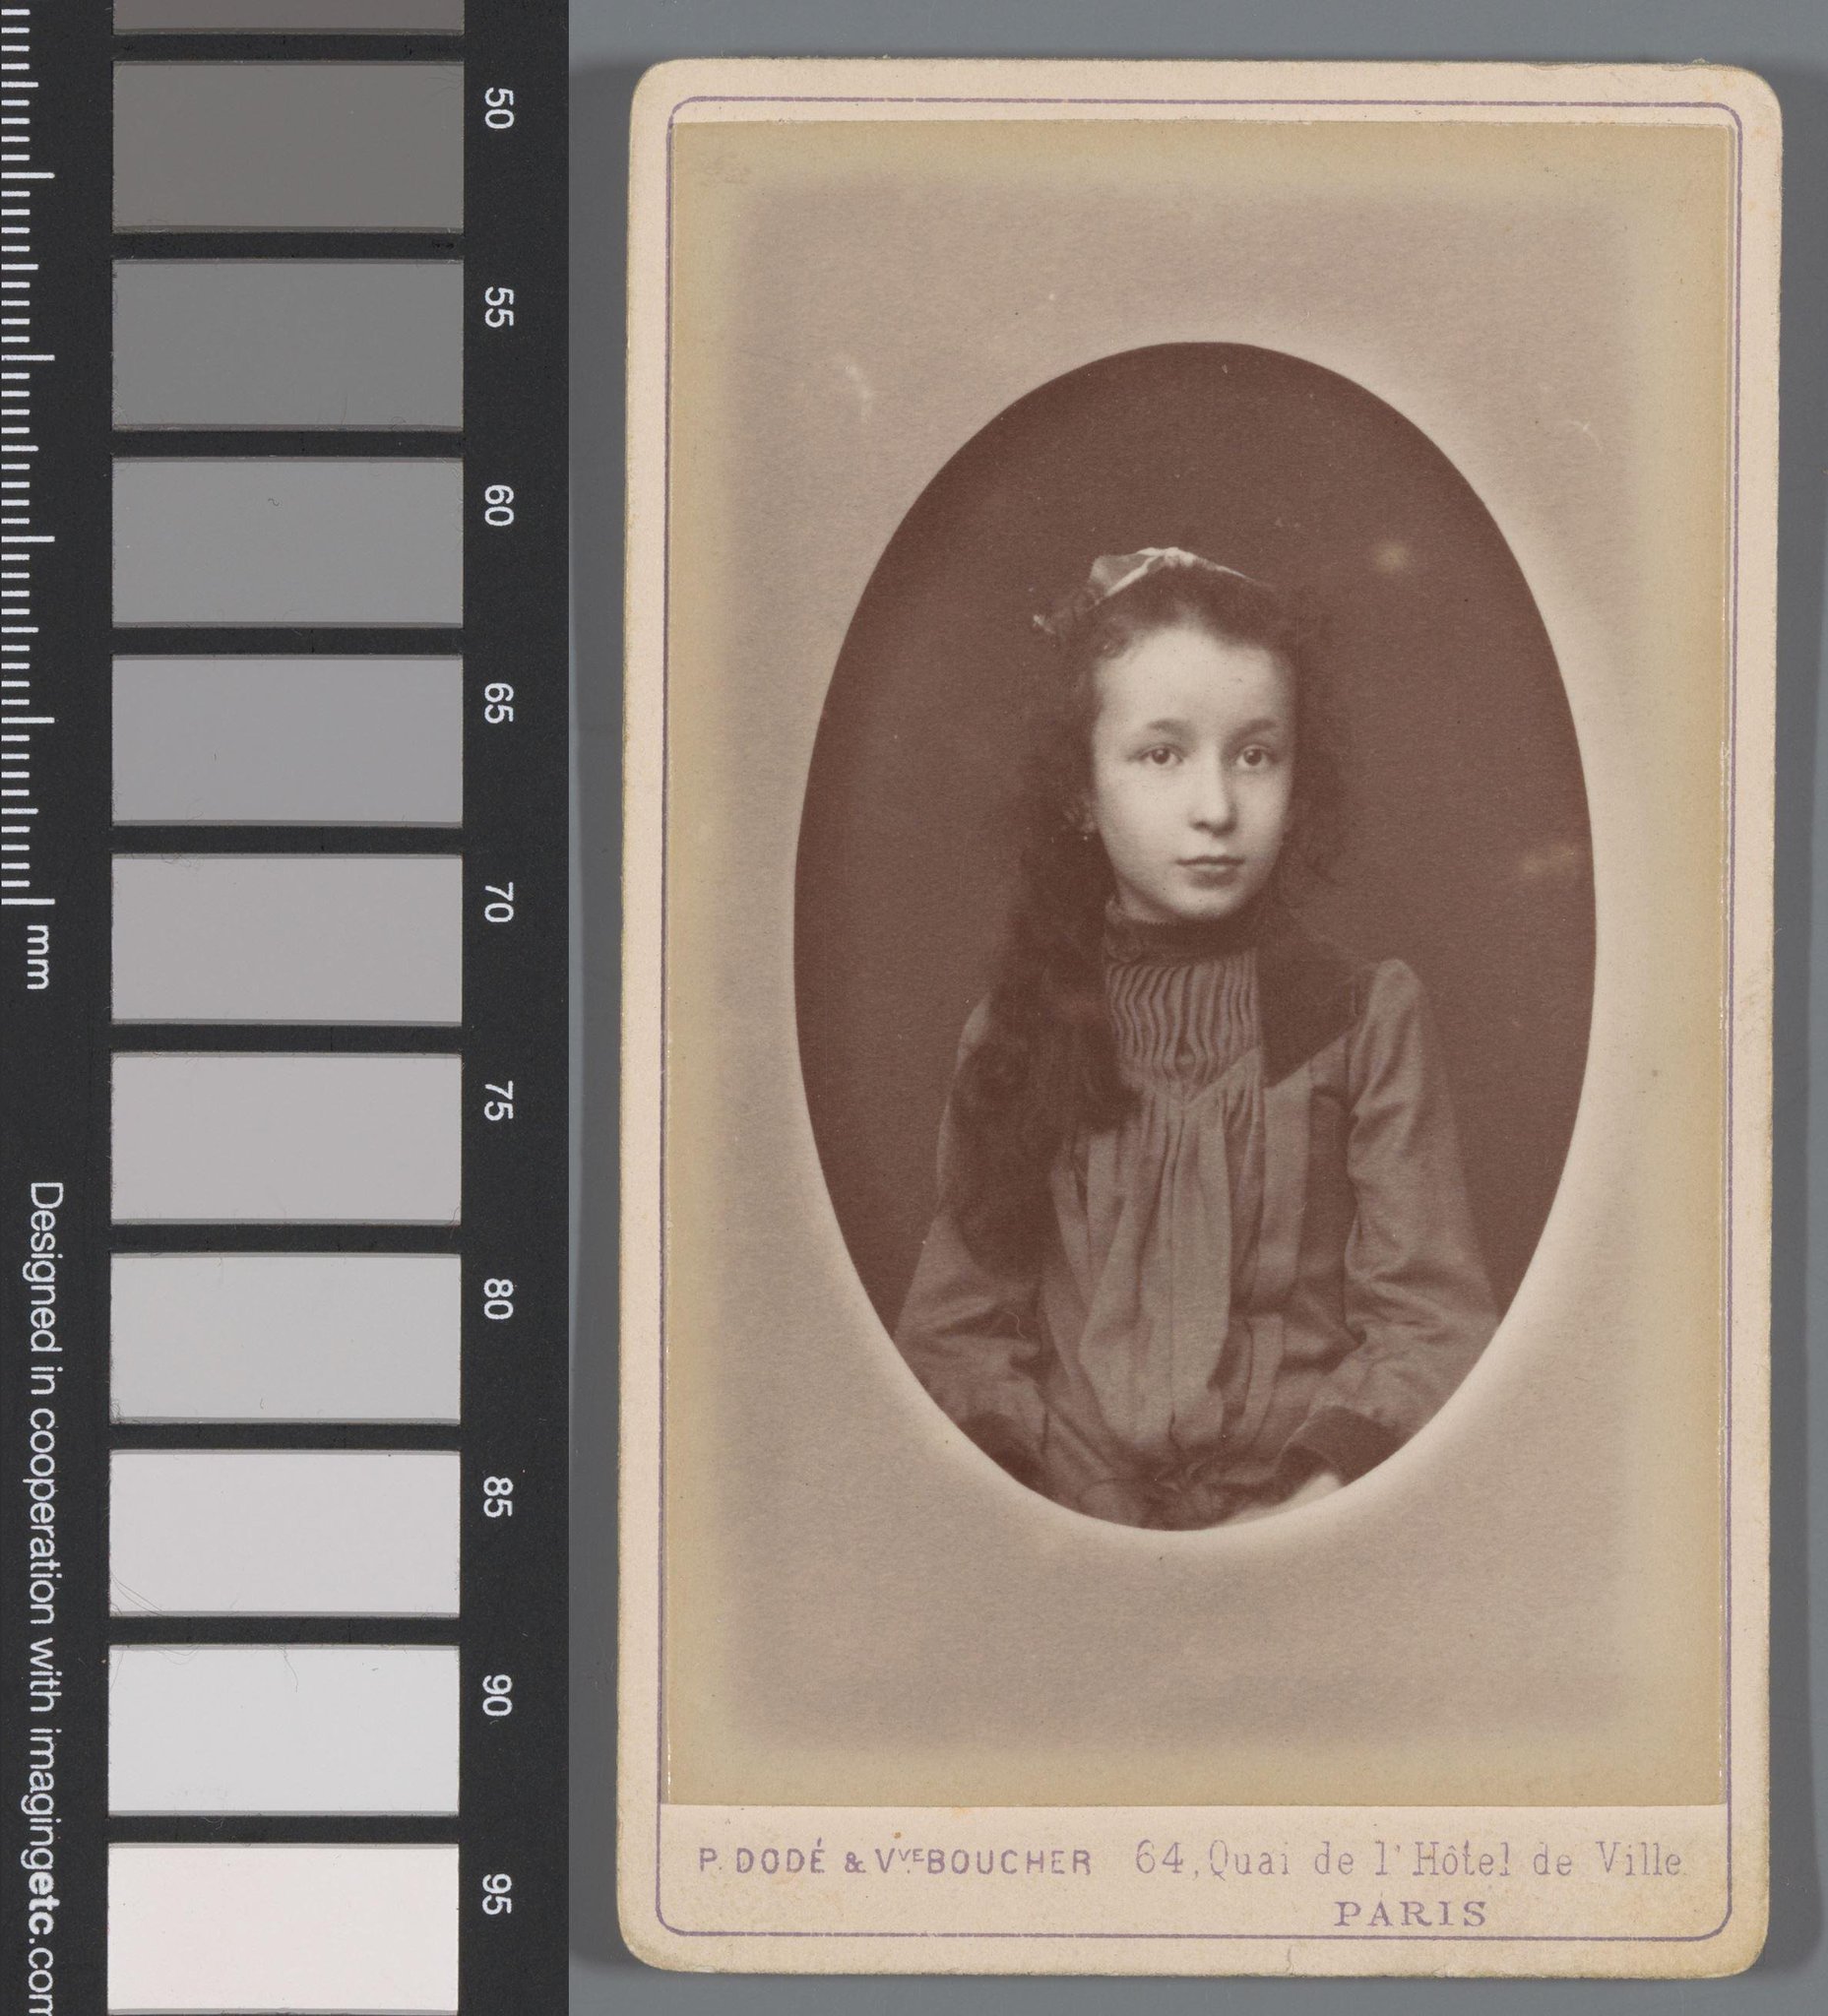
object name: semi enamel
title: Portret van een onbekend meisje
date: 1880-1910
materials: cardboard, celluloid, paper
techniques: albumen print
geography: paris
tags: girl (child between toddler and youth), anonymous historical person portrayed, paris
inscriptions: inscription: ‘Photographie/ du/ Portrait-Carte d'Identité/ P. Dodé & Vve. Boucher/ 64, Quai de l'Hôtel de Ville./ précèdemment/ (14, Boulevard du Temple)/ Paris/ No.../ D. Hutinet Paris’, inscription: ‘P. Dodé & Vve. Boucher 64, Quai de l'Hôtel de Ville/ Paris’, number: ‘32055’